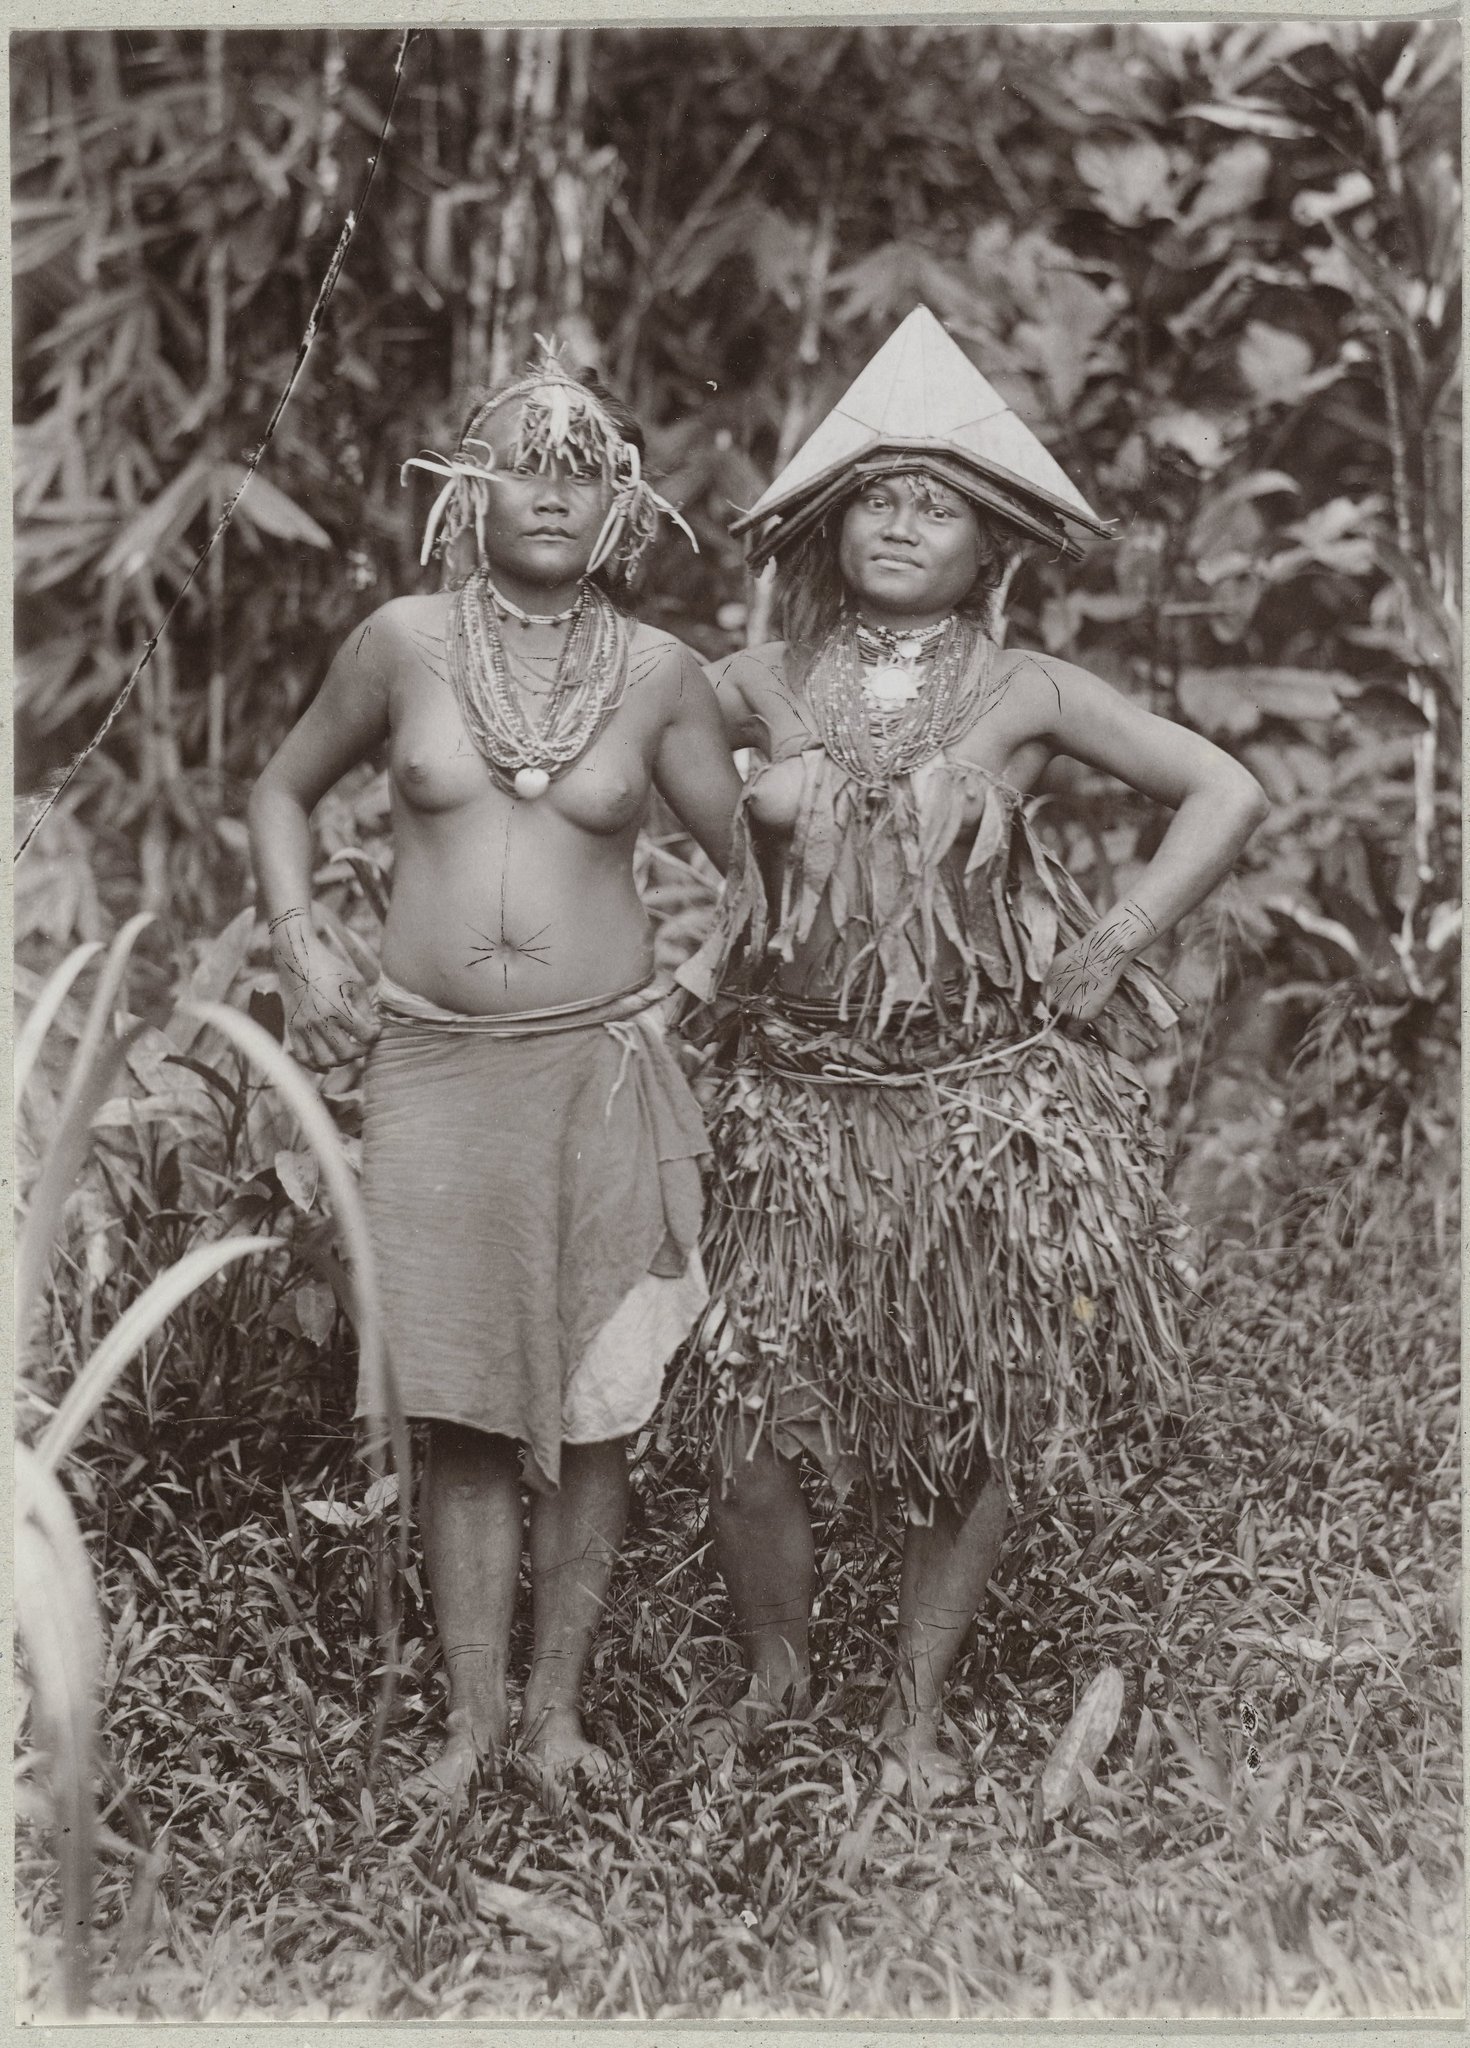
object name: photograph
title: Portret van twee onbekende jonge vrouwen op Pagai in de dracht van het eiland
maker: christiaan benjamin nieuwenhuis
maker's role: publisher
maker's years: 1863-1922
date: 1891-1912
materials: paper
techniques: albumen print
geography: mentawai islands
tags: anonymous historical persons portrayed in a double portrait - bb - woman, folk costume, regional costume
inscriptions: inscription: ‘Pageische meisjes’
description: Twee jonge vrouwen op Pagei in de dracht van het eiland. Het rechter meisje draagt een rieten rok en de linker draagt een doek om haar middel. Op het hoofd dragen zij versieringen van respectievelijk een driehoekige muts en een hoofdband met daaronder gestoken riet. Beide vrouwen dragen halskettingen.